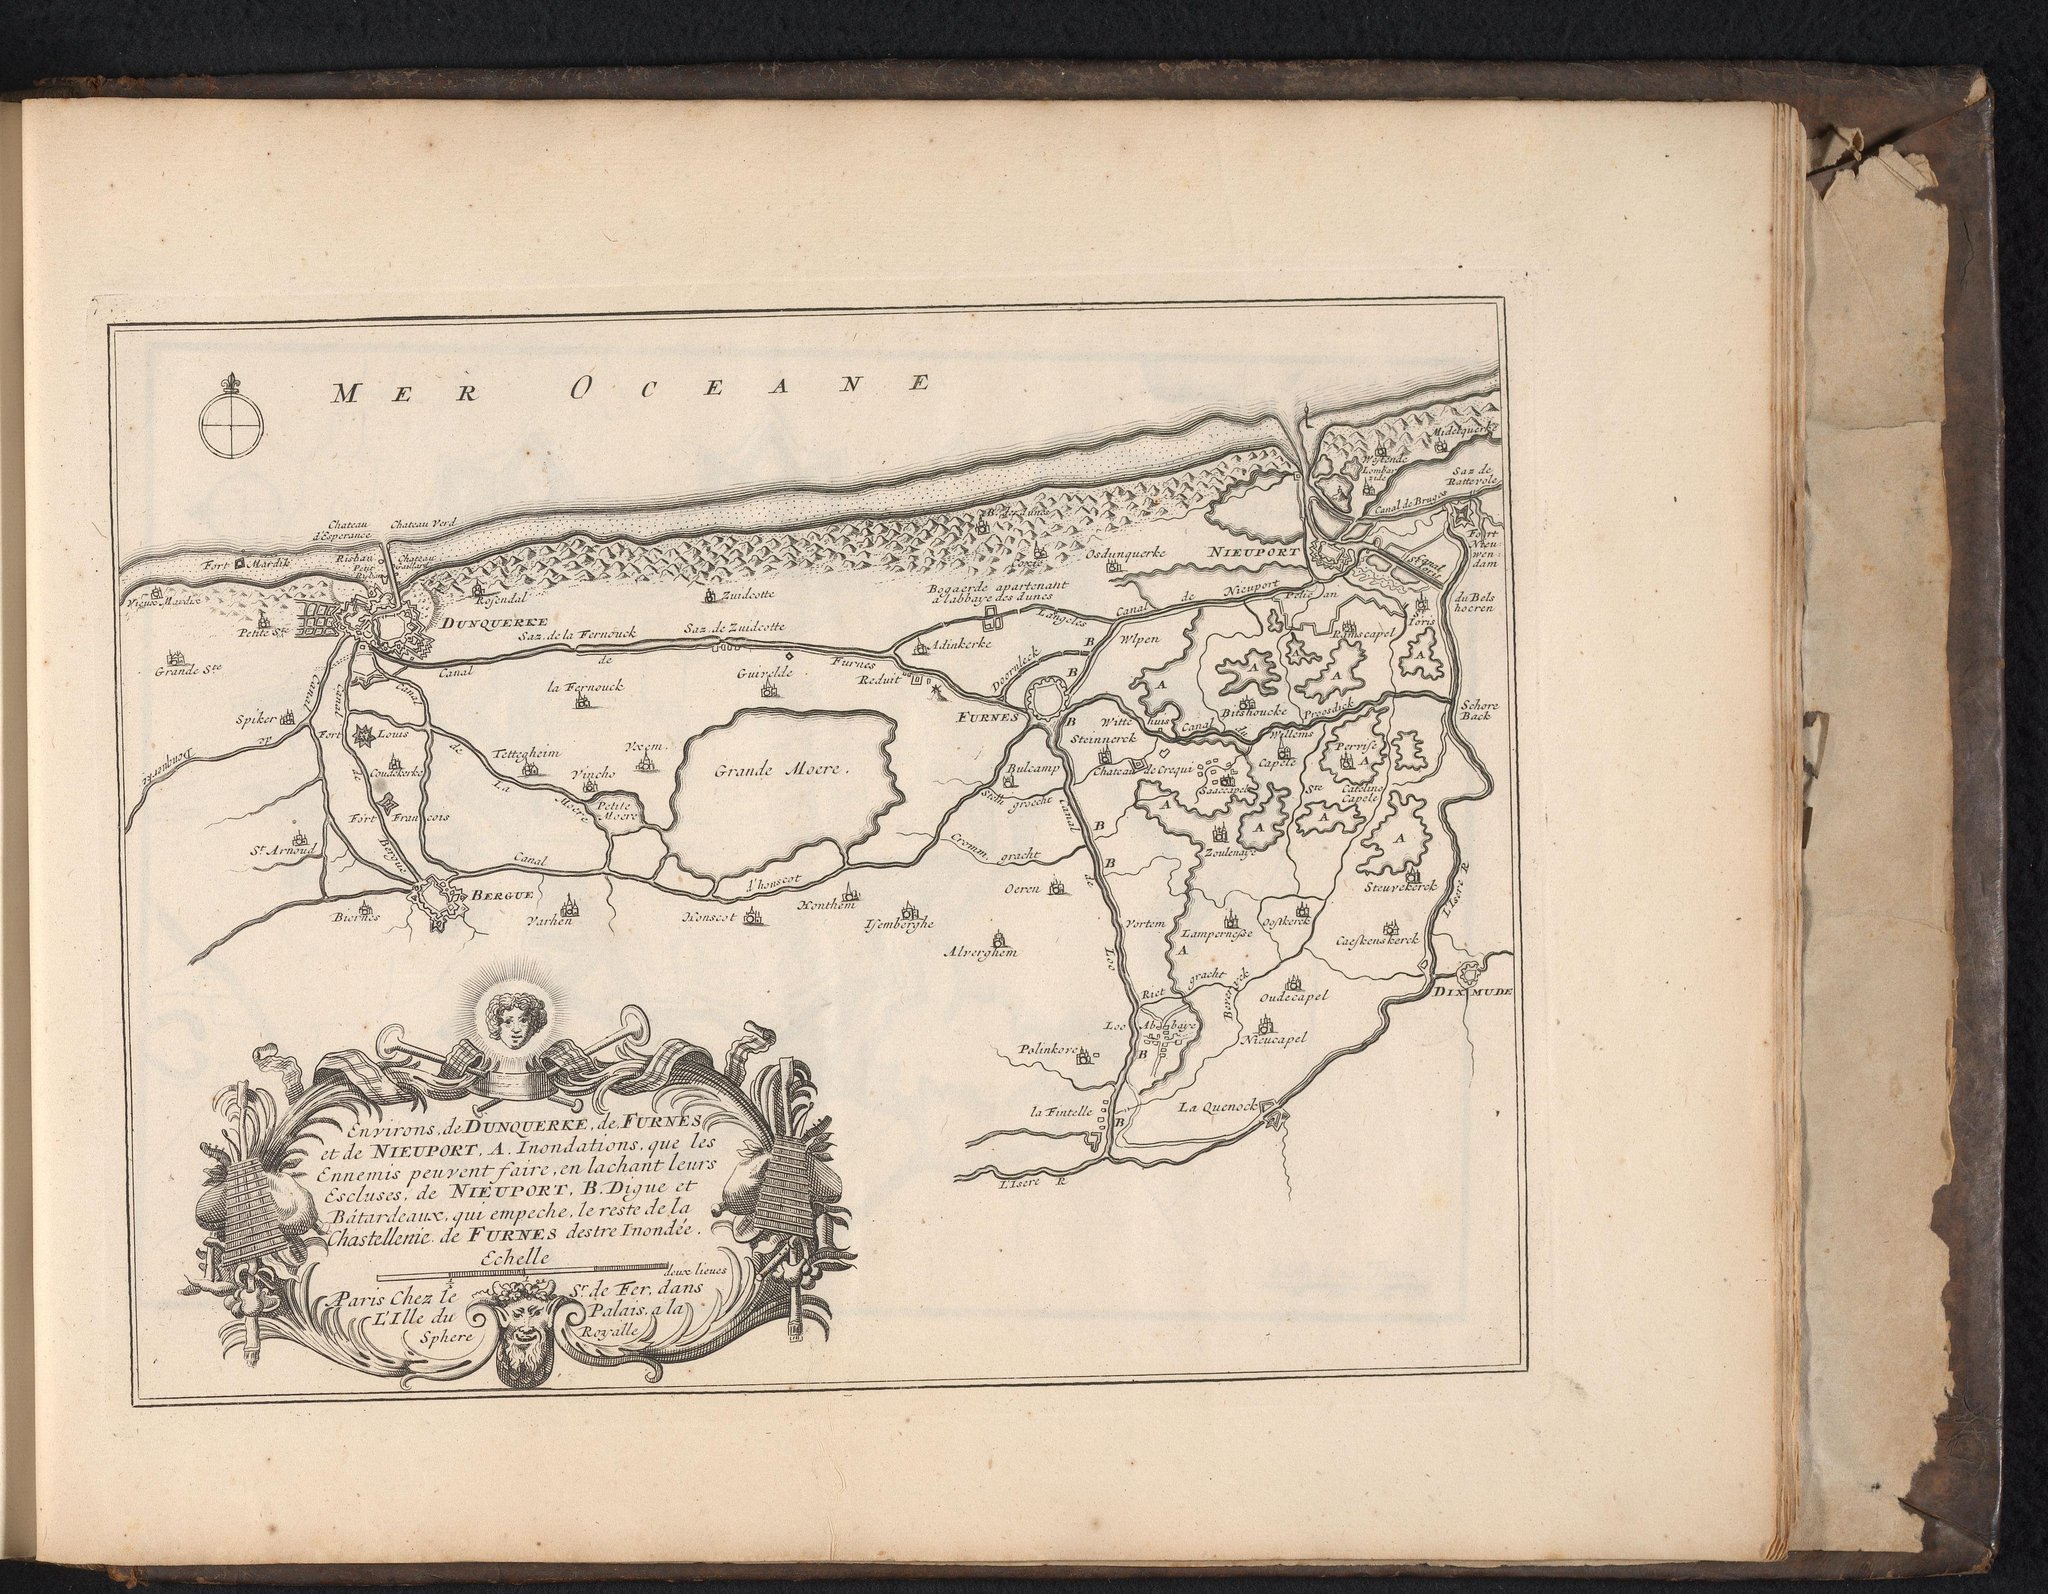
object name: print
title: Environs, de Dunquerke, de Furnes et de Nieuport (...)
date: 1693-1696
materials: paper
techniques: engraving, etching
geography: paris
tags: fortress, maps of separate countries or regions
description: Kaart van de Vlaamse kust tussen Duinkerke en Nieuwpoort. Onderdeel van het tweede van twee delen van het prentwerk: Le Theatre de la Guerre, dans les Pays-Bas, waarvan het titelblad uitgegeven is in 1696. Het prentwerk bestaat in totaal (beide delen) uit 52 platen met plannen (afkomstig van Sébastien Le Prestre, Seigneur de Vauban) van vermaarde sterke steden en vestingen in de Negenjarige Oorlog in de Nederlanden. Identiek aan de plaat die voorkomt in: Les forces de l'Europe, uitgegeven tussen 1693-1697. Titel en opschriften in het Frans.